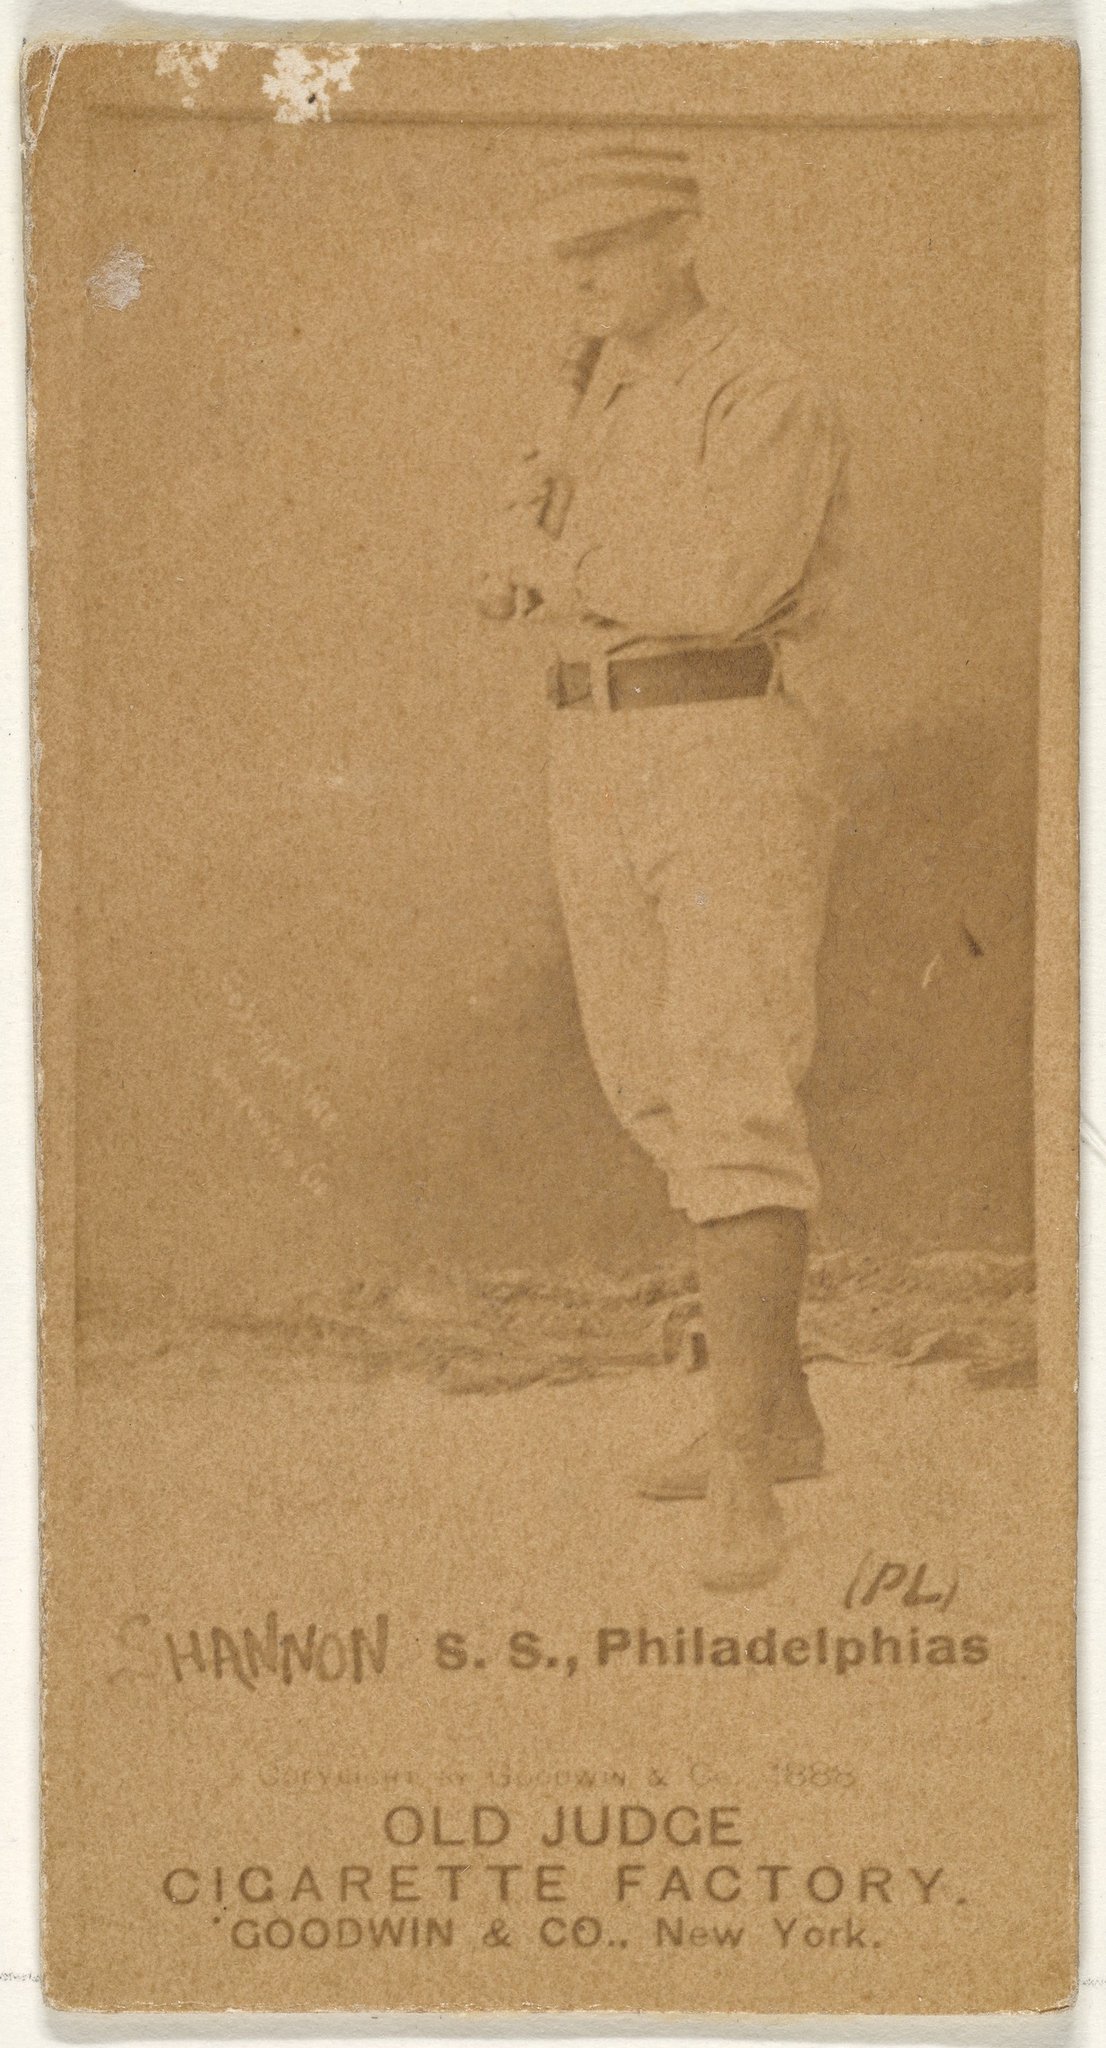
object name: baseball card, photograph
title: Daniel Webster "Dan" Shannon, Shortstop, Philadelphia, from the Old Judge series (N172) for Old Judge Cigarettes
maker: goodwin & company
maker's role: publisher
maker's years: 1850-1950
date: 1888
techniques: albumen silver print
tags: men,portraits,baseball,athletes